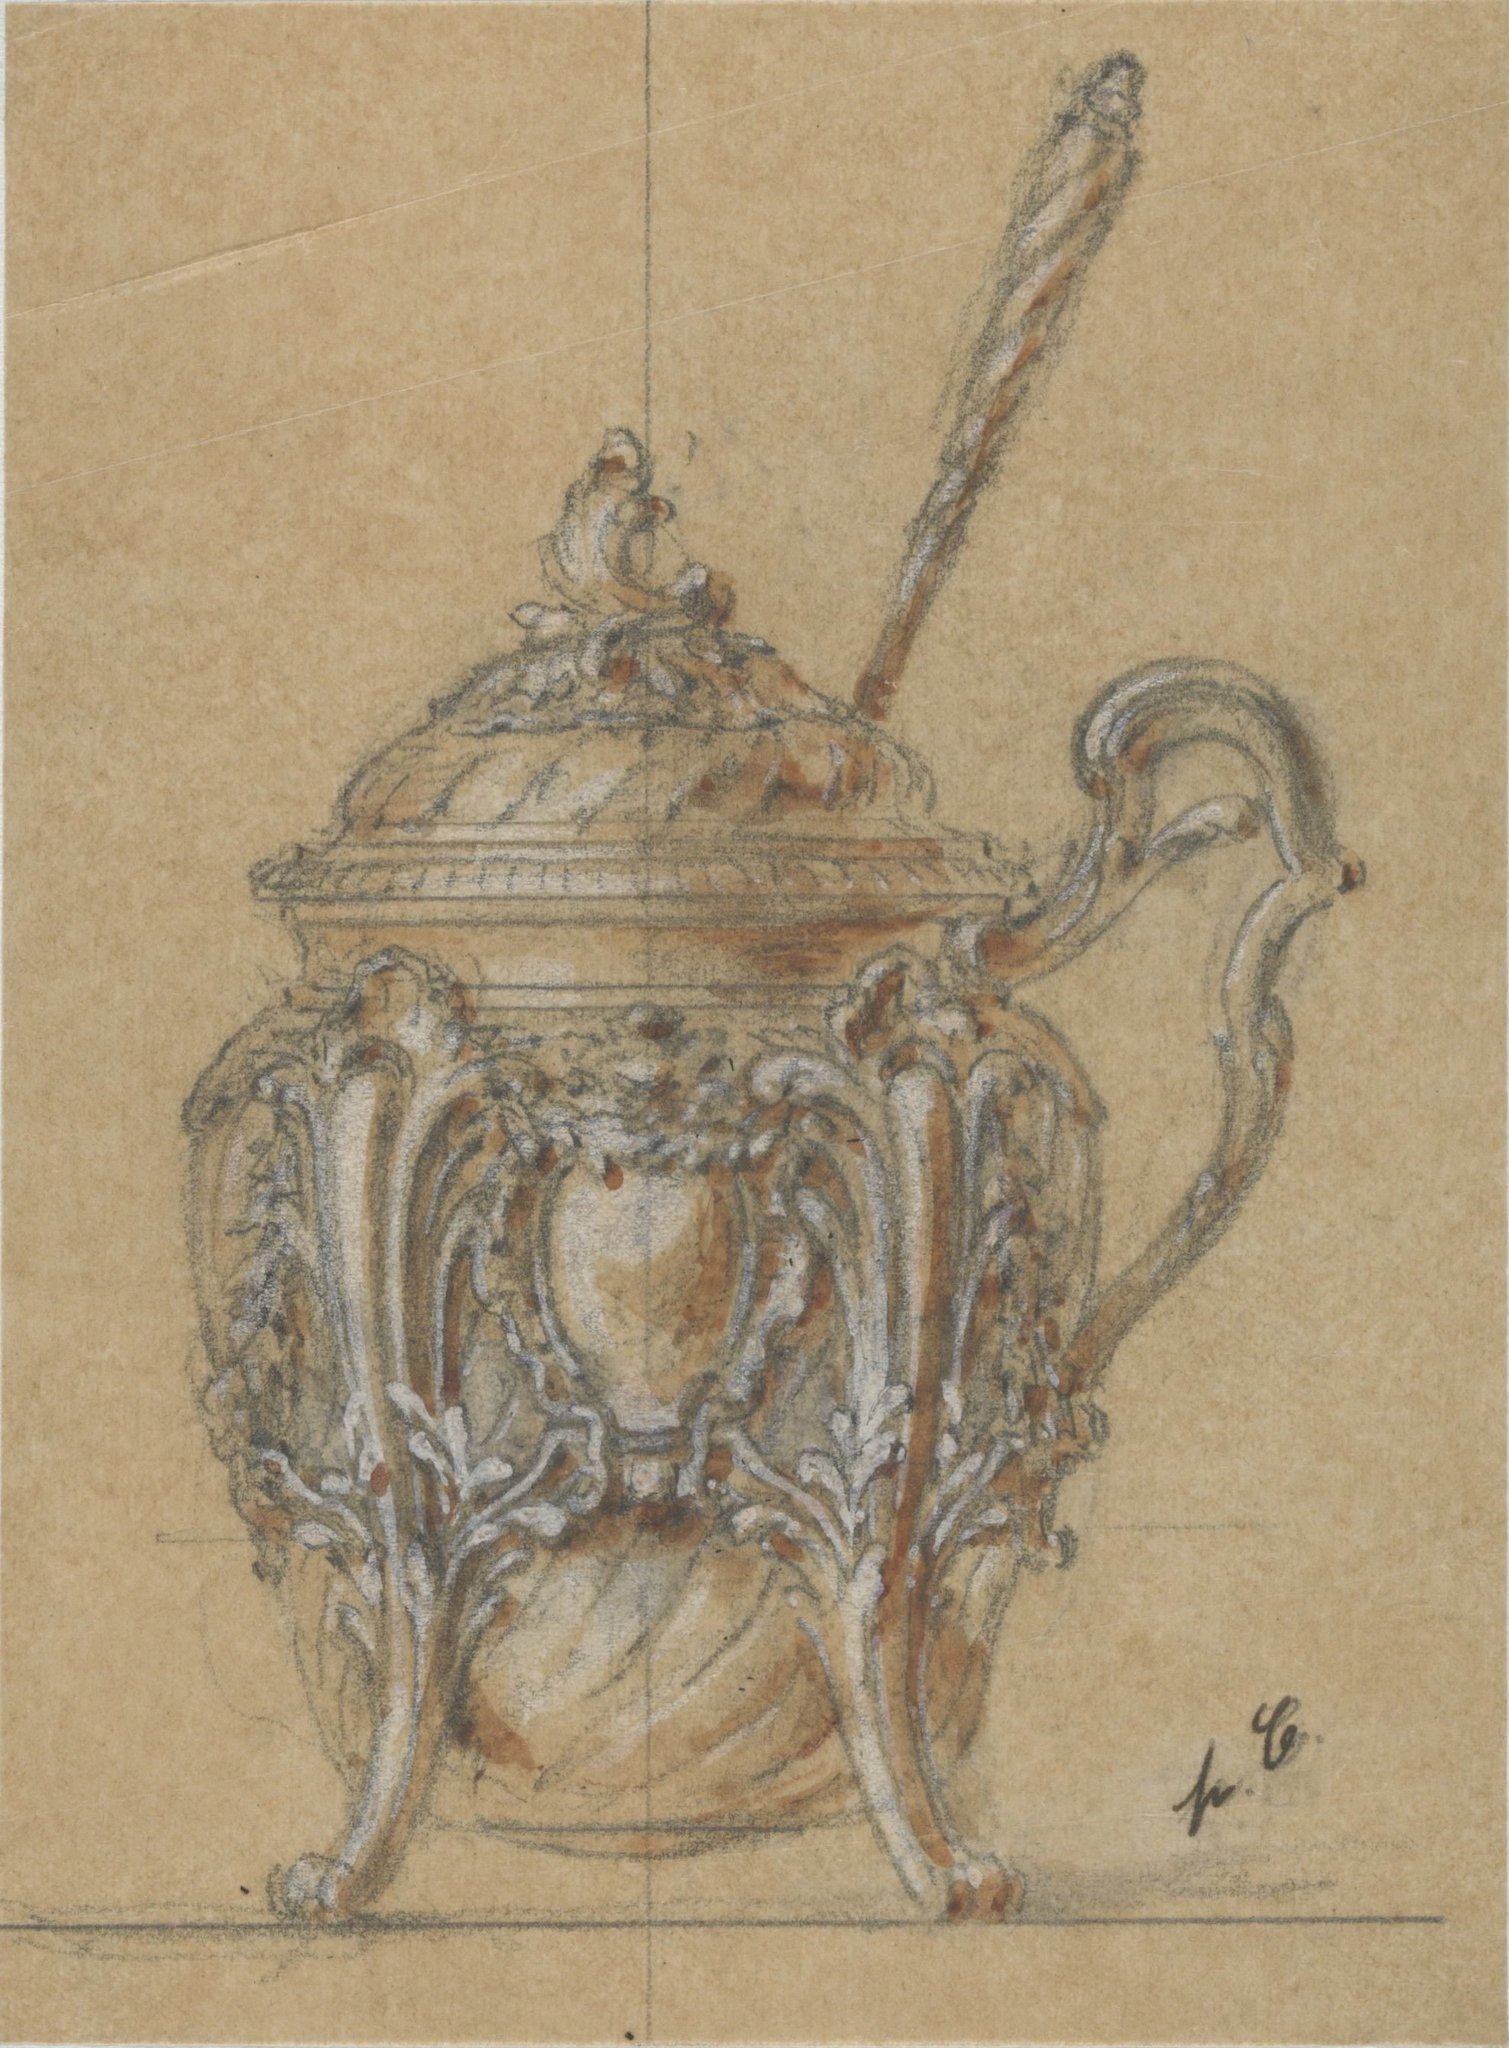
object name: design drawing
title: Ontwerp voor mosterdpot met deksel en lepel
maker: henri cameré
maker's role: designer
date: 1864-1894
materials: paint, pencil, paper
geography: paris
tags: mustard, table-ware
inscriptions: signature